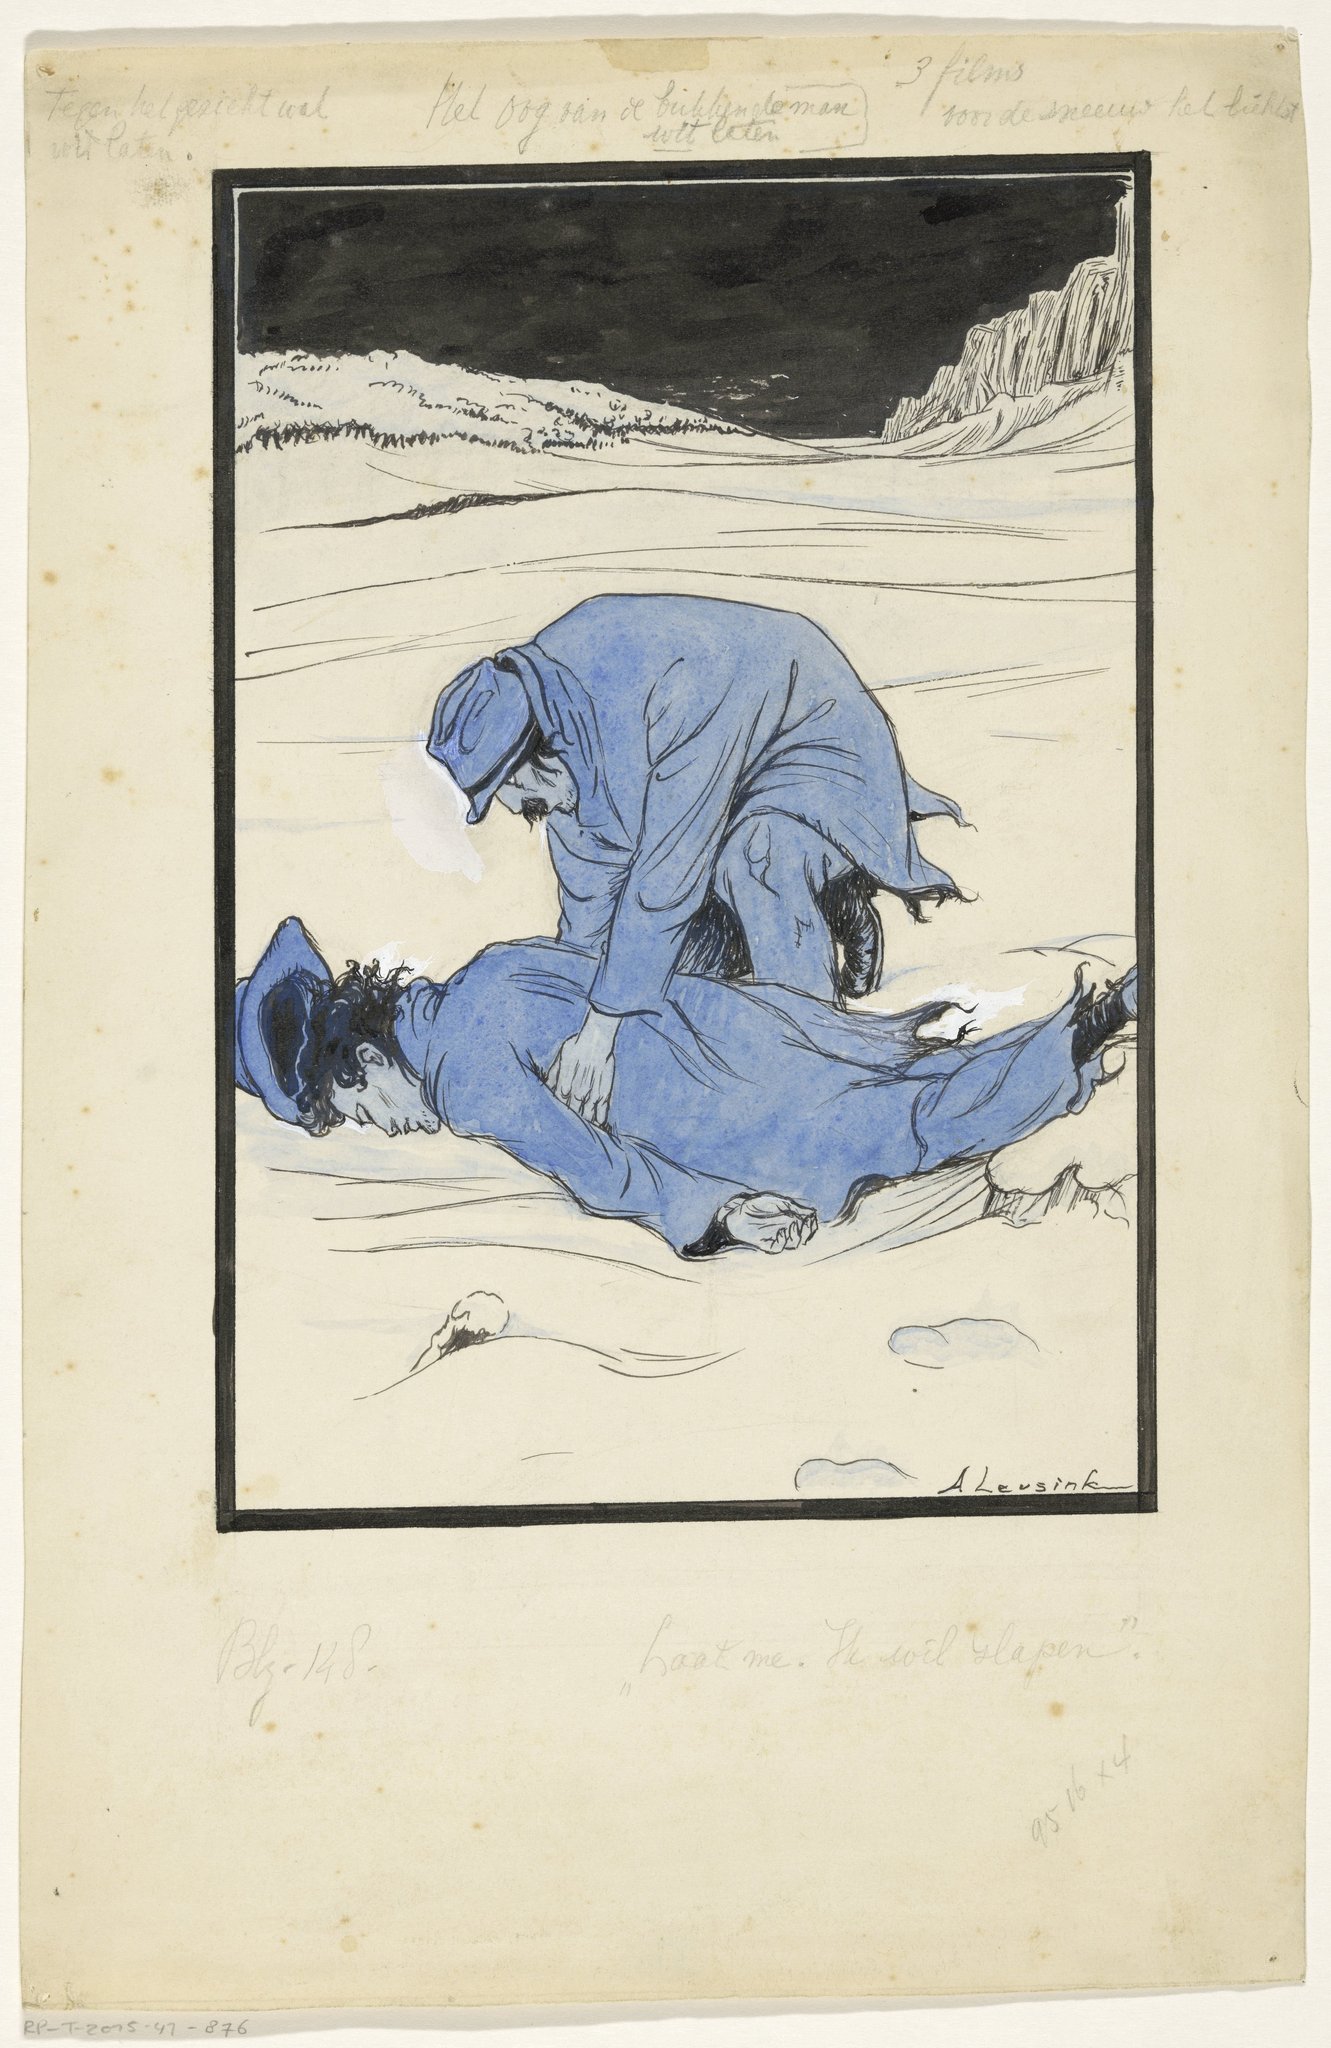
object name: boekillustratie ontwerp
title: Joost ligt bewusteloos in de sneeuw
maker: anny leusink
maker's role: draughtsman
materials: paint, ink, paper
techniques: brush, pen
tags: lying face downwards, snow, unconsciousness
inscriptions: signature: ‘A Leusink’, annotation: ‘Blz. 148. "Laat me. Ik wil slapen".’, collector's mark: Lugt 2228, :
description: Joost ligt bewusteloos op zijn buik in de sneeuw. Zijn hoed is van zijn hoofd gevallen. Zijn kameraad buigt zich over hem heen en probeert hem wakker te schudden. Op de achtergrond een sneeuwlandschap.